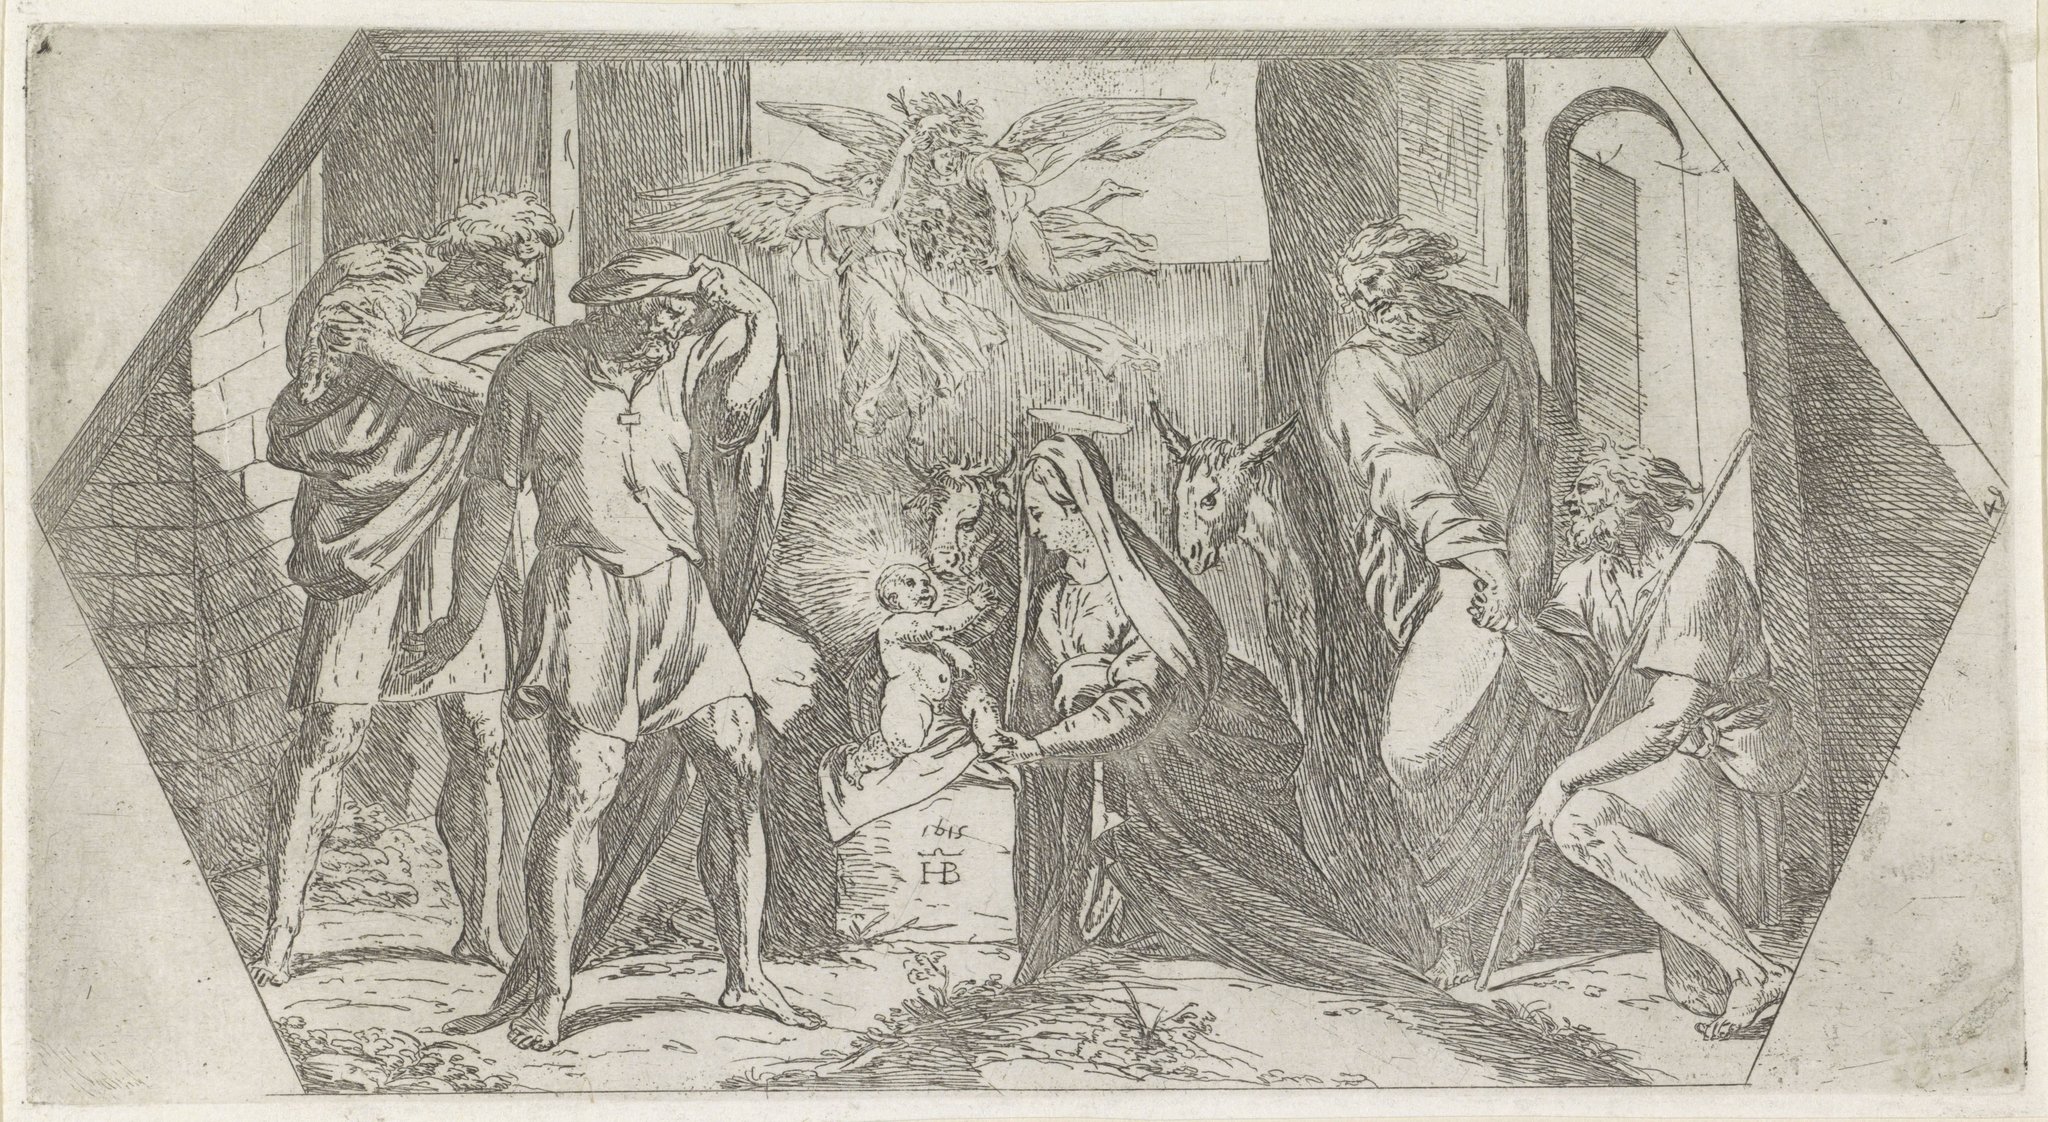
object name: print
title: Schilderingen in de Loggia van Rafaël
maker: orazio borgianni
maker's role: print maker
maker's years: 1578-1616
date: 1615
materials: paper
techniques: etching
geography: italy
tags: adoration of the christ-child by the shepherds; mary and joseph present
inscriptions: collector's mark: Lugt 2165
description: In een gemetselde stal aanbidden de herders, Maria en Jozef het Christuskind. Boven het Christuskind zweven engelen.